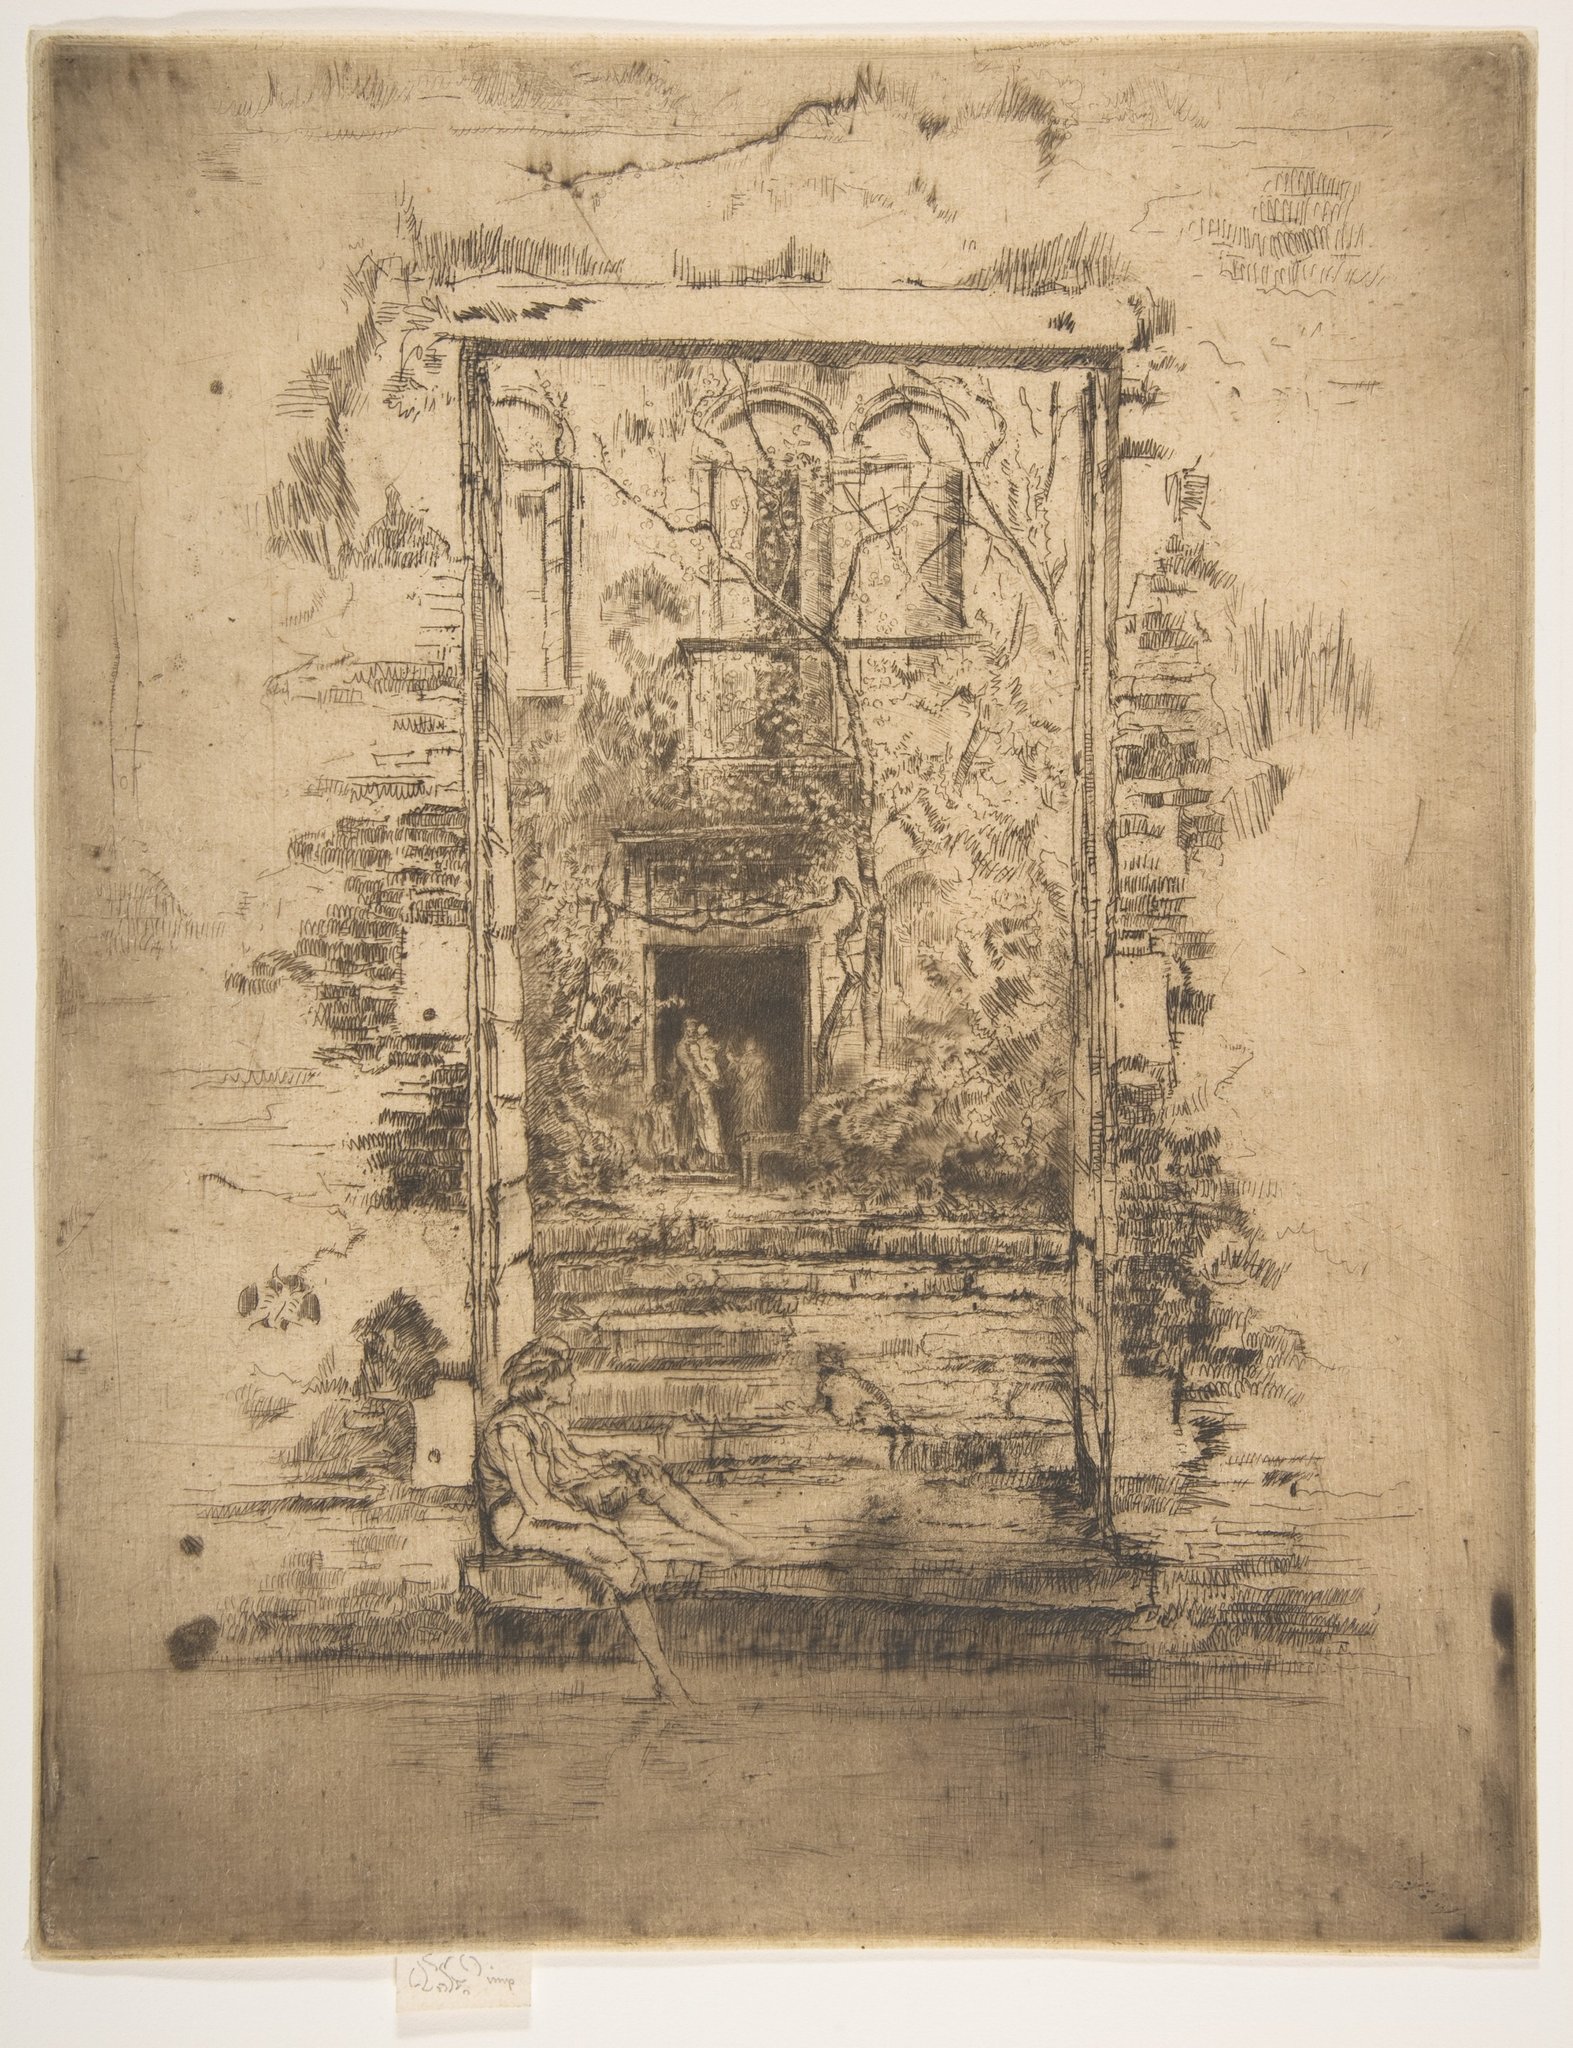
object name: print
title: The Garden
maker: james mcneill whistler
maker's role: artist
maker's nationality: american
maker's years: 1834-1903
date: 1879-1880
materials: ink, paper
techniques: drypoint, etching, printing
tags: stairs,gardens,men,venice